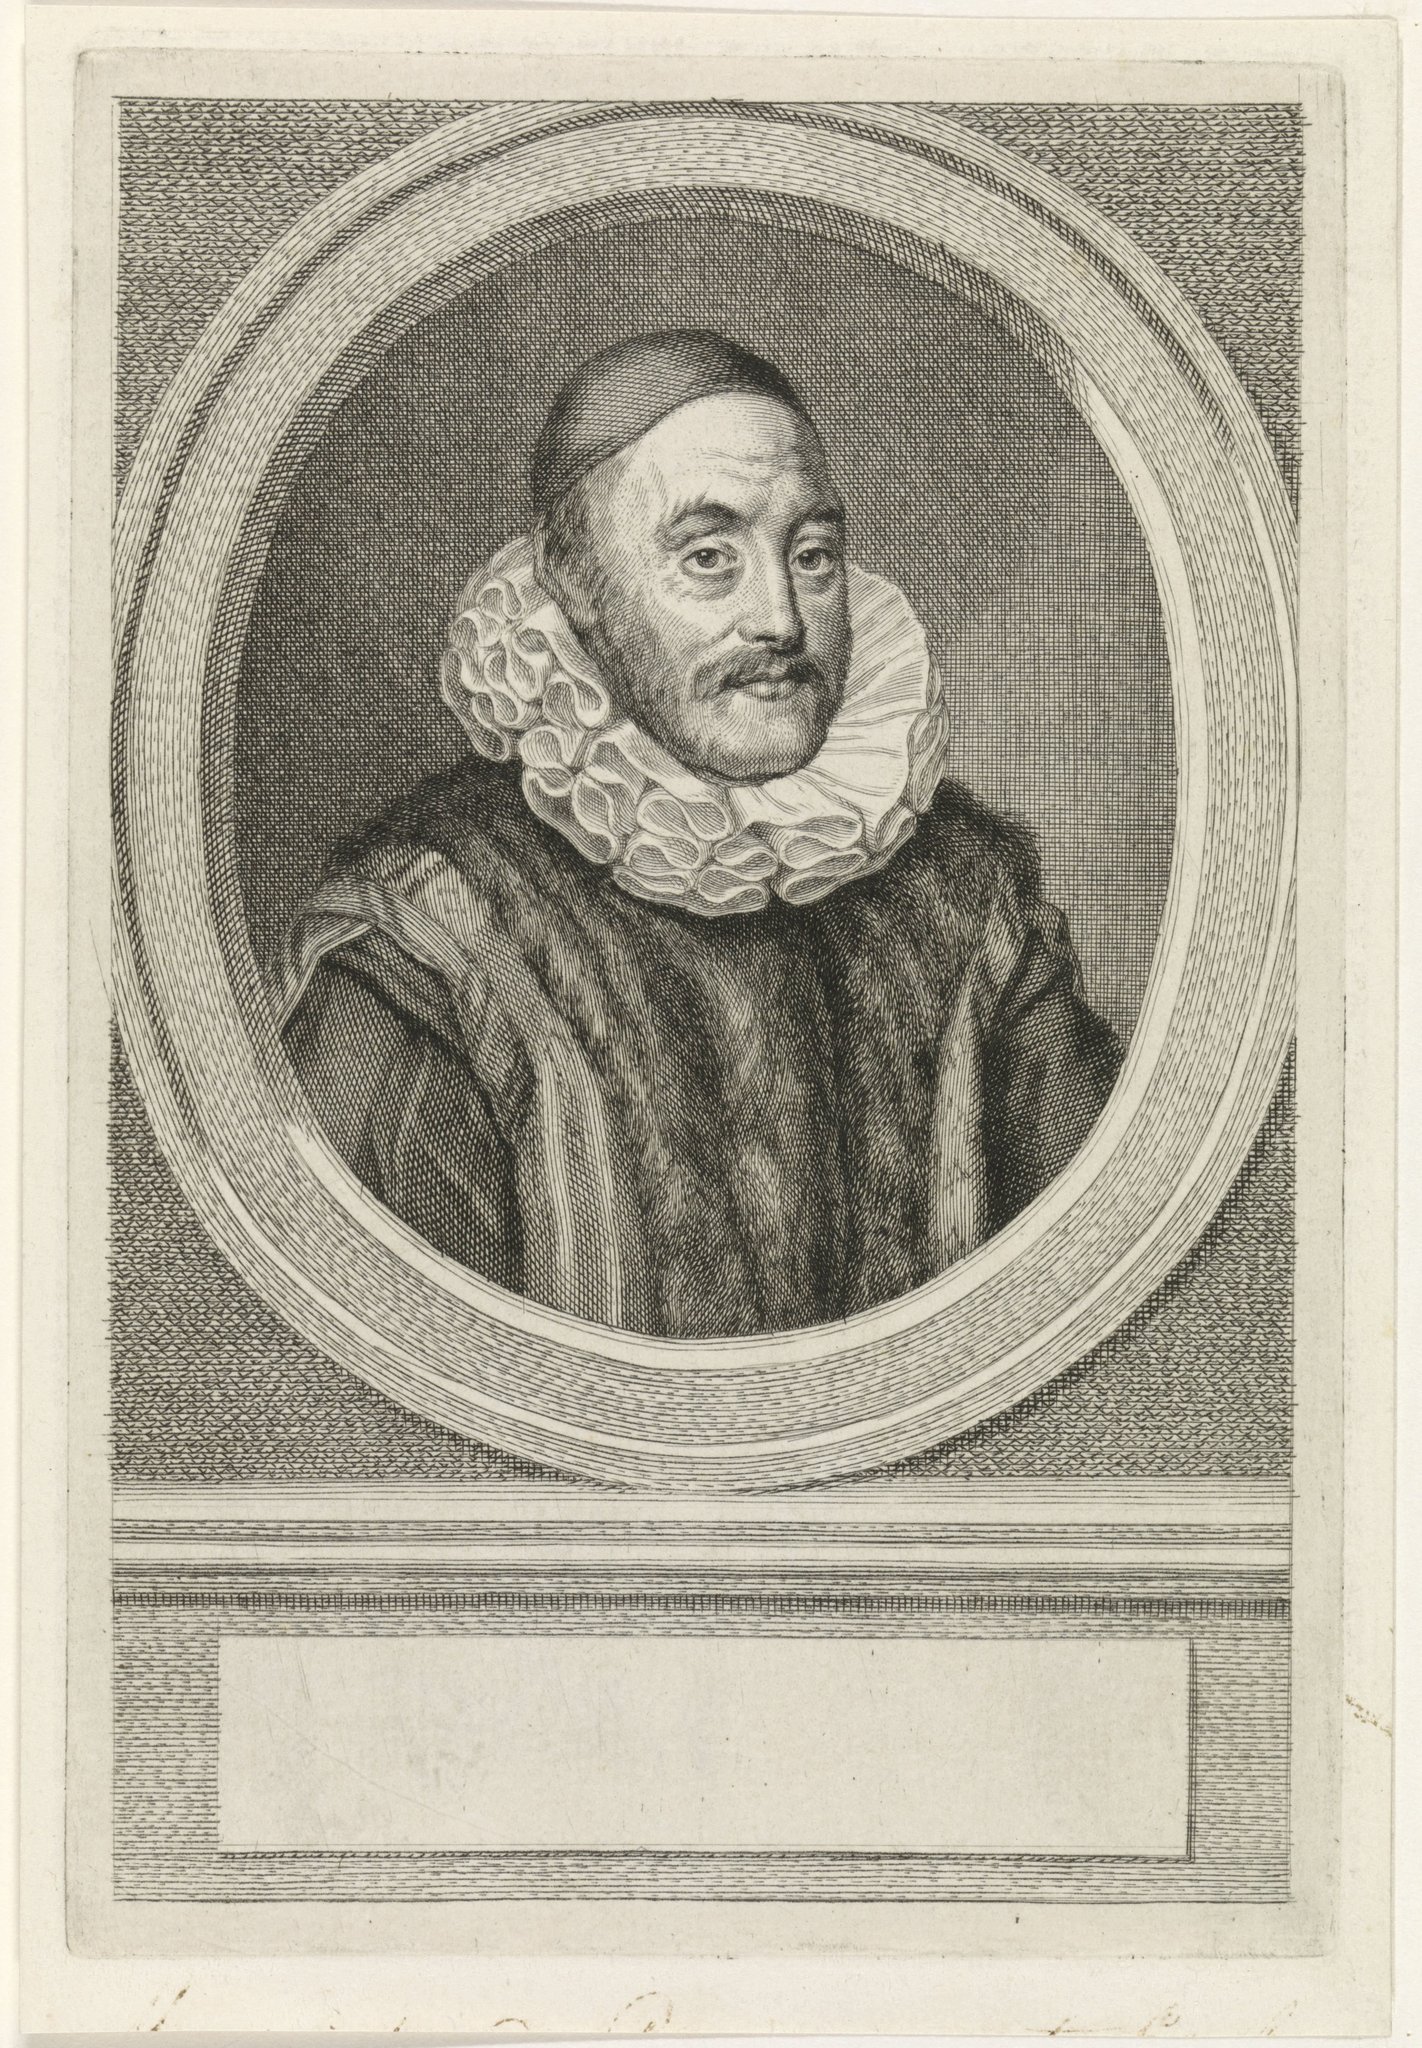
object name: print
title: Portret van Petrus Rijcke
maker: jacob houbraken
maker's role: draughtsman, print maker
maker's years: 1698-1780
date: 1749-1780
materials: paper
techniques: engraving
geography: amsterdam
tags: historical persons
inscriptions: collector's mark: Lugt 2228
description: Latere staat van deze prent is oorspronkelijk bedoeld als aanvulling op Jan Wagenaars ‘Vaderlandsche historie’* en was zo vanaf 1796 verkrijgbaar bij Johannes Allart te Amsterdam. Voor de advertentie waarin Allart de 60 portretten en 7 platen, allen gegraveerd door Houbraken, ter aanvulling op Wagenaars ‘Vaderlandsche historie’ aanbiedt, zie RP-P-OB-77.766. *Van dit werk zijn in de achttiende eeuw meerdere uitgaves verschenen, zoals: Wagenaar, Jan. Vaderlandsche historie, vervattende de geschiedenissen der Vereenigde Nederlanden (…). 21 delen. Amsterdam: Isaak Tirion, 1749-1759. Wagenaar, Jan. Vaderlandsche historie, vervattende de geschiedenissen der nu Vereenigde Nederlanden (…). 21 delen. Amsterdam: weduwe Isaak Tirion, 1770. Wagenaar, Jan. Vaderlandsche historie, vervattende de geschiedenissen der nu Vereenigde Nederlanden (…). 21 delen. Amsterdam, Leiden, Dordrecht en Harlingen: P. Schouten e.a., 1782. Wagenaar, Jan. Vaderlandsche historie, vervattende de geschiedenissen der nu Vereenigde Nederlanden (…). 21 delen. Amsterdam: Johannes Allart, 1790-1796.